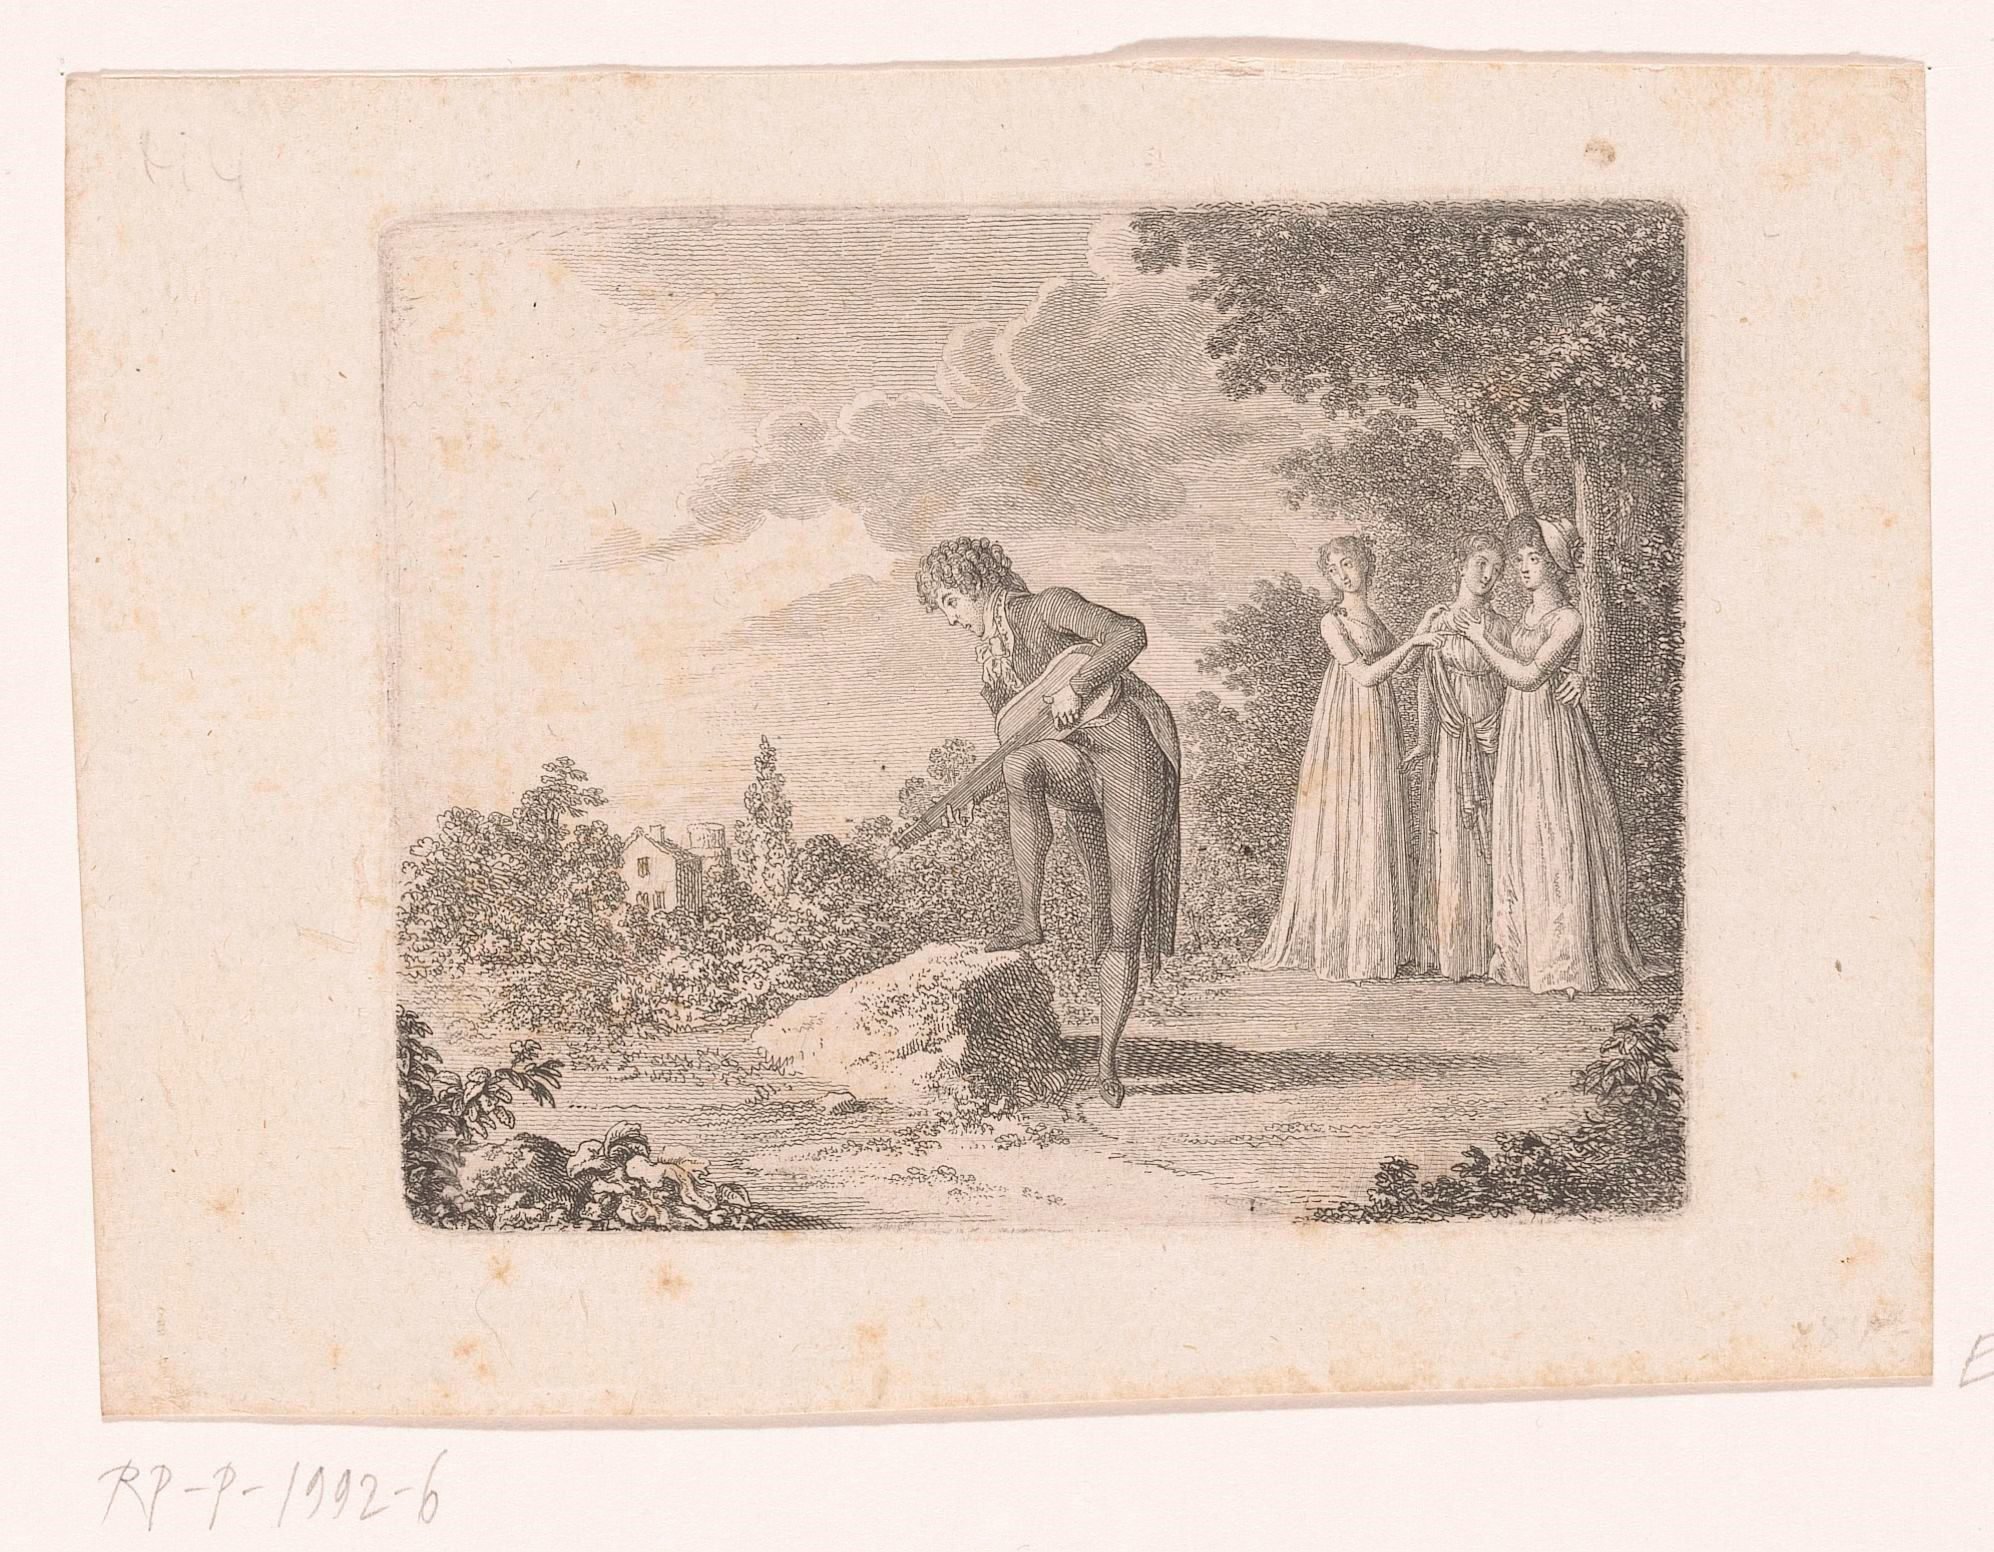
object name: print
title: Mr. de Vollange speelt op zijn gitaar, terwijl rechts drie dames luisteren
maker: daniel nikolaus chodowiecki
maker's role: draughtsman, print maker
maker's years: 1726-1801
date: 1798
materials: paper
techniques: etching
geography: berlin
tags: adolescent, young woman, maiden, one person playing string instrument (plucked) - cc - out of doors, landscapes, actor (on the stage)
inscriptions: collector's mark: Lugt 2228